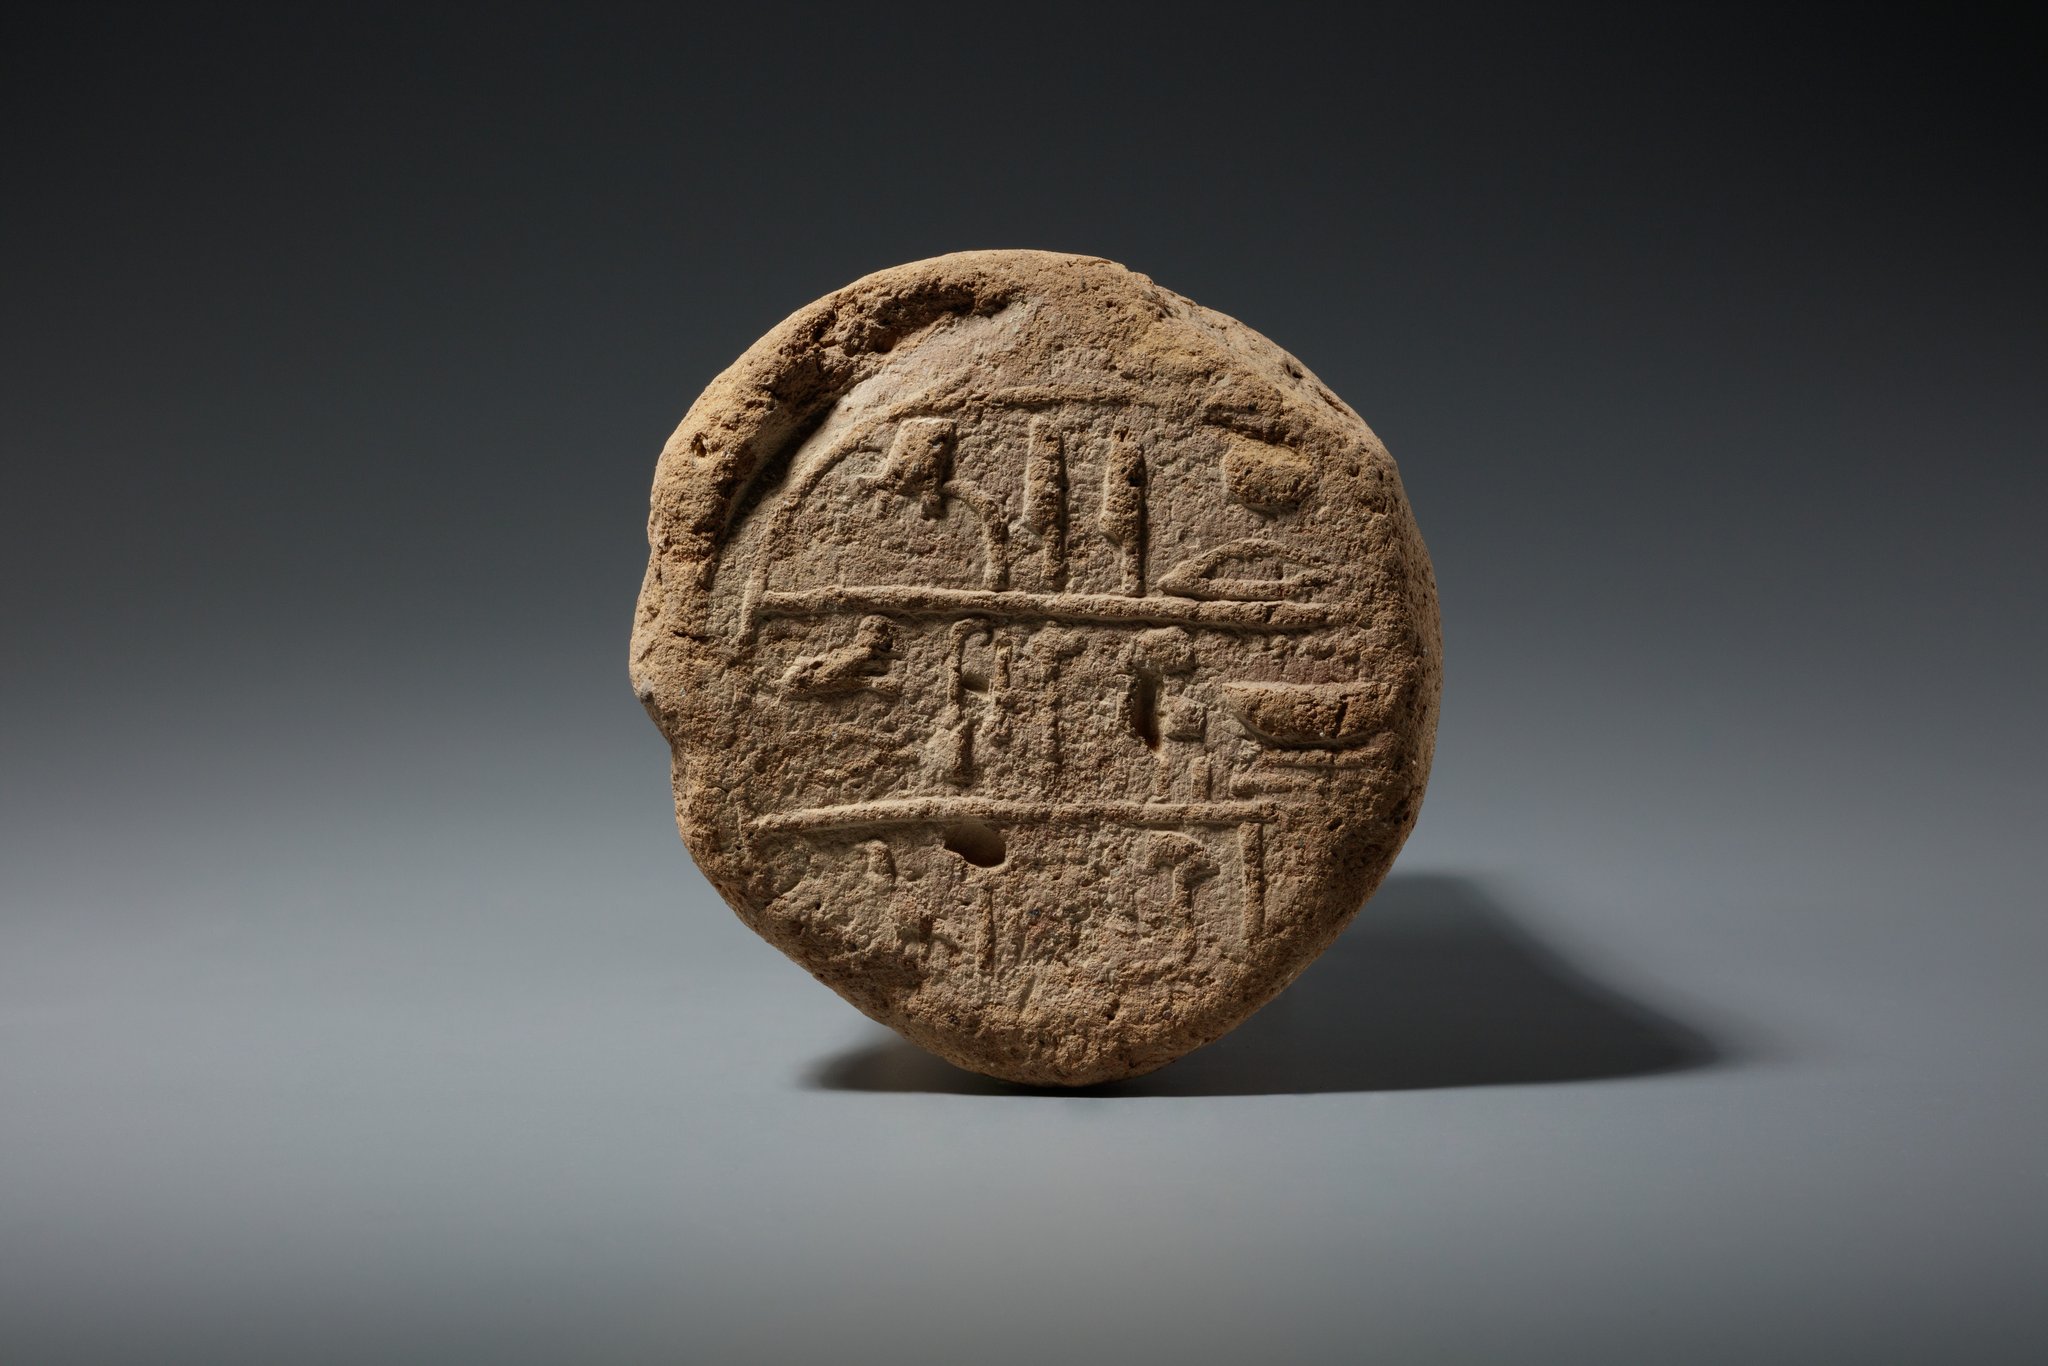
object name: cone, davy 508, wesy, scribe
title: Funerary Cone of Wesy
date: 1550-1352 BCE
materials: pottery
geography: egypt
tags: hieroglyphs